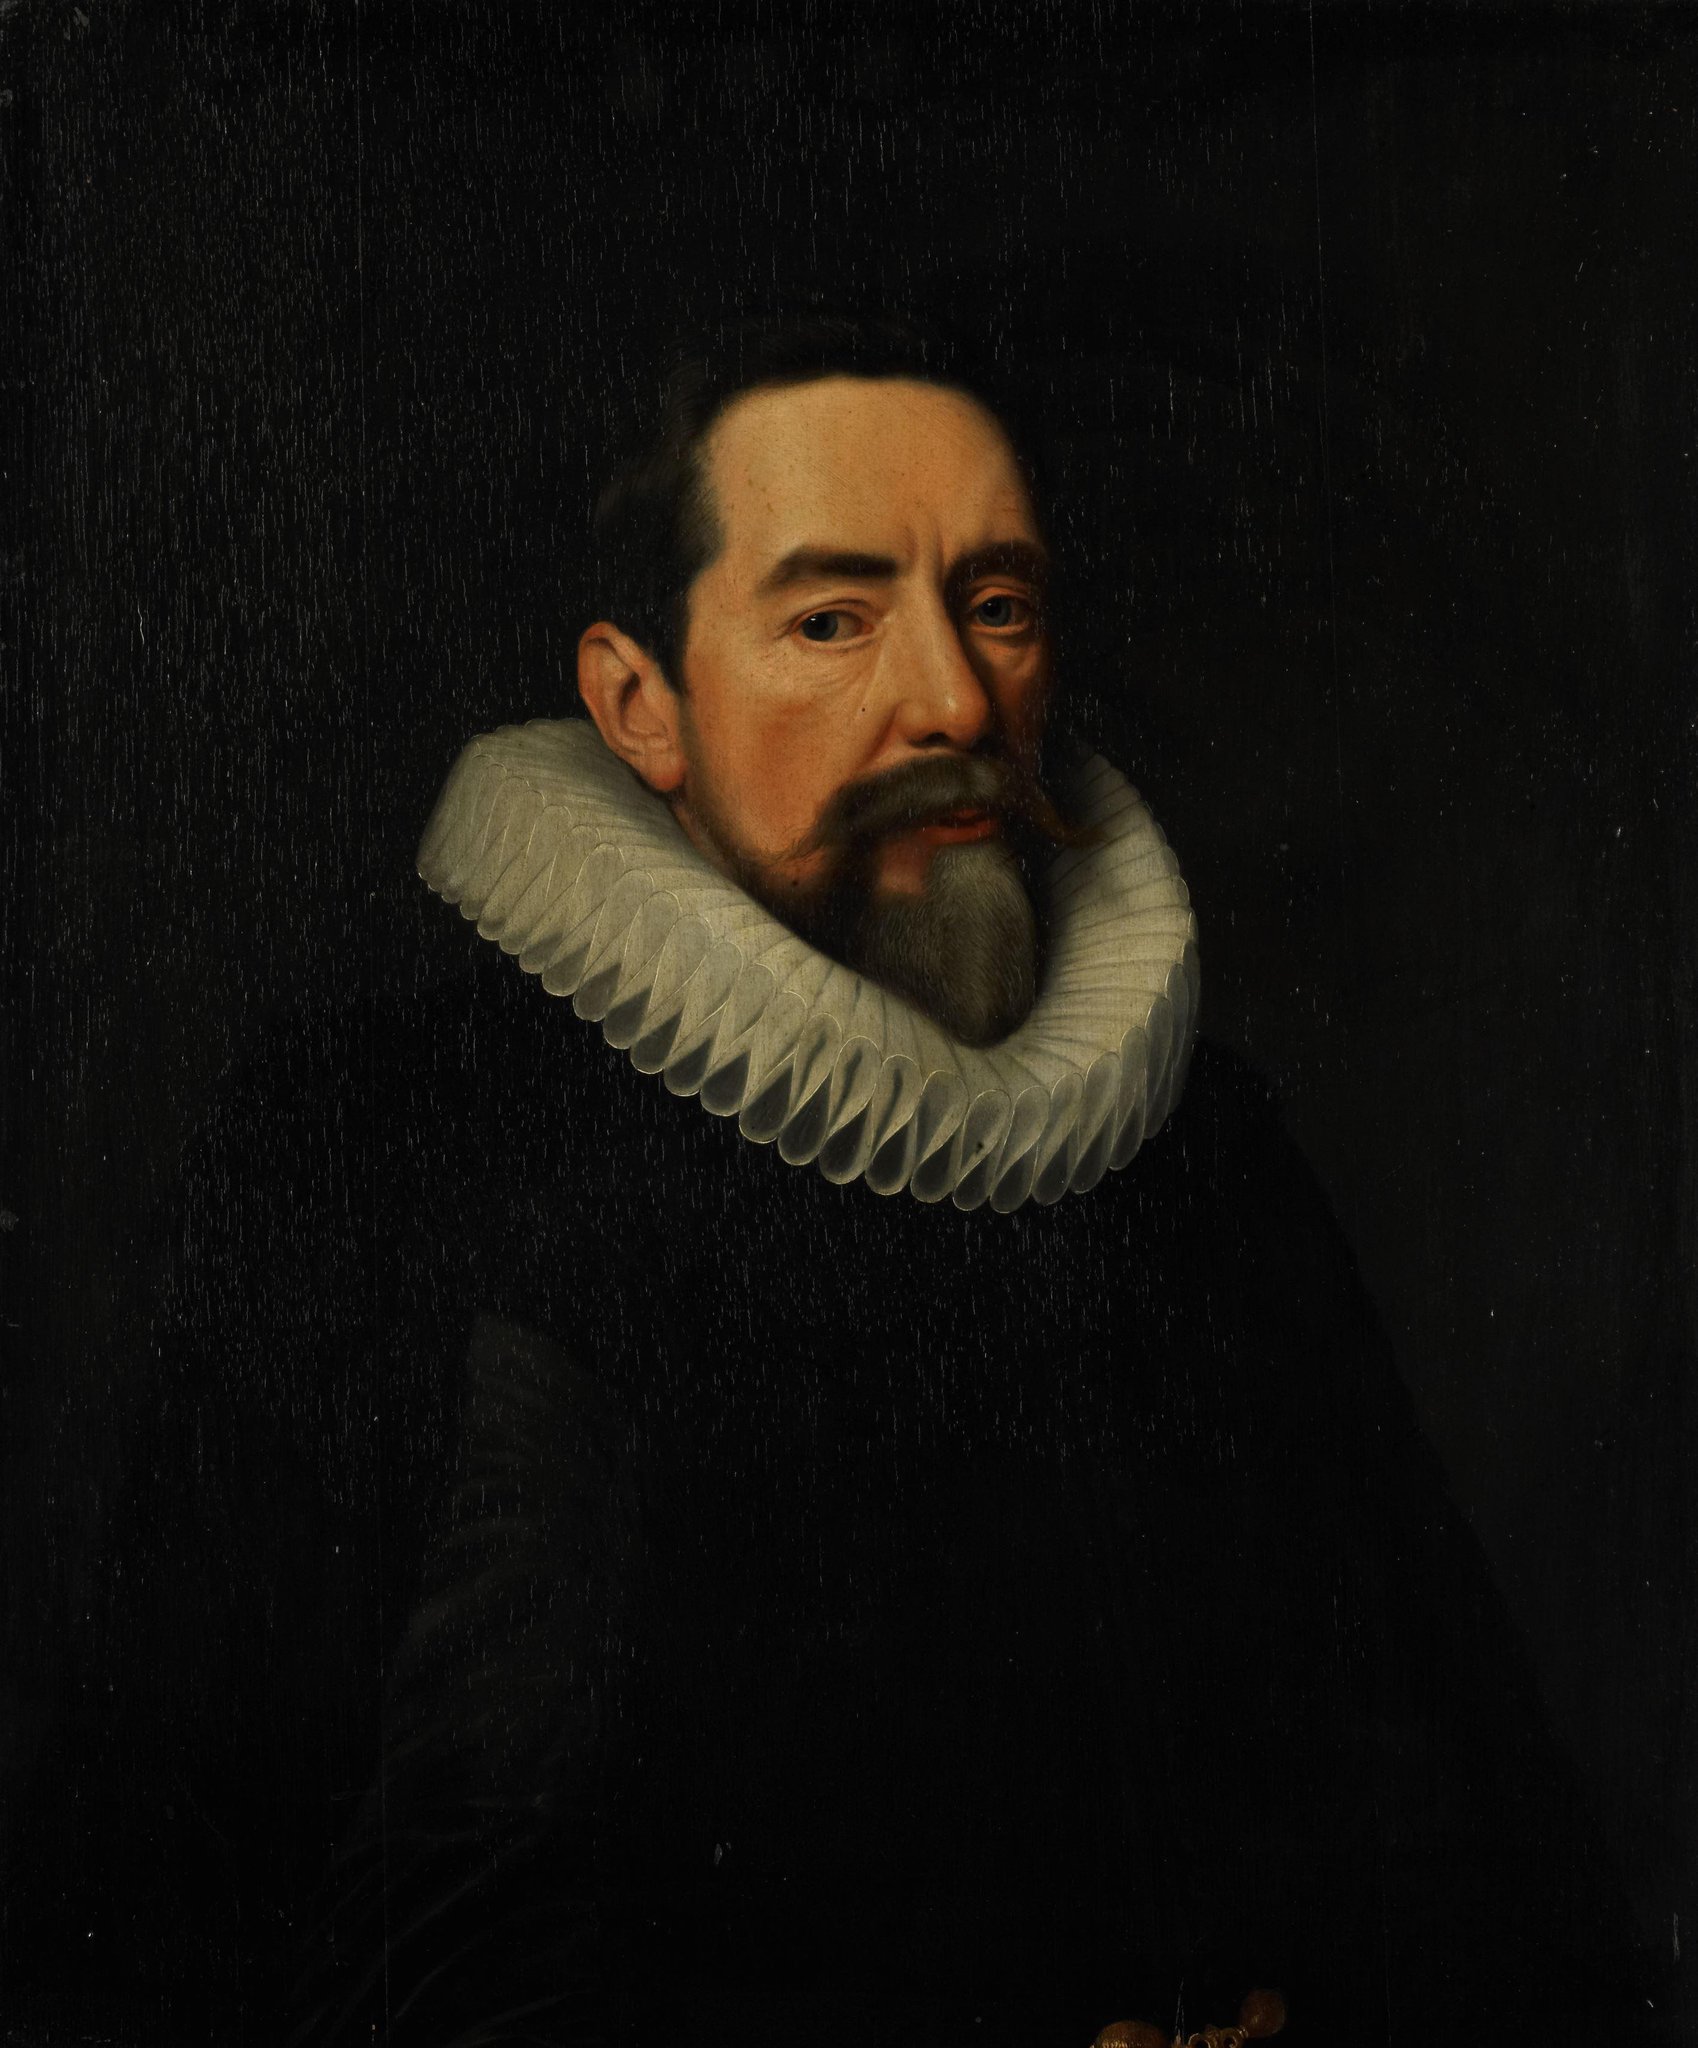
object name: painting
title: Portrait of a Man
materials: oil, panel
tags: neck-gear ~ clothing (with name), anonymous historical person portrayed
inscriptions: date, centre left: ‘A.º 1619’, inscription, centre left: ‘Ætatis 54’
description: Portret van een man, ten halven lijve naar rechts, om de hals een plooikraag.